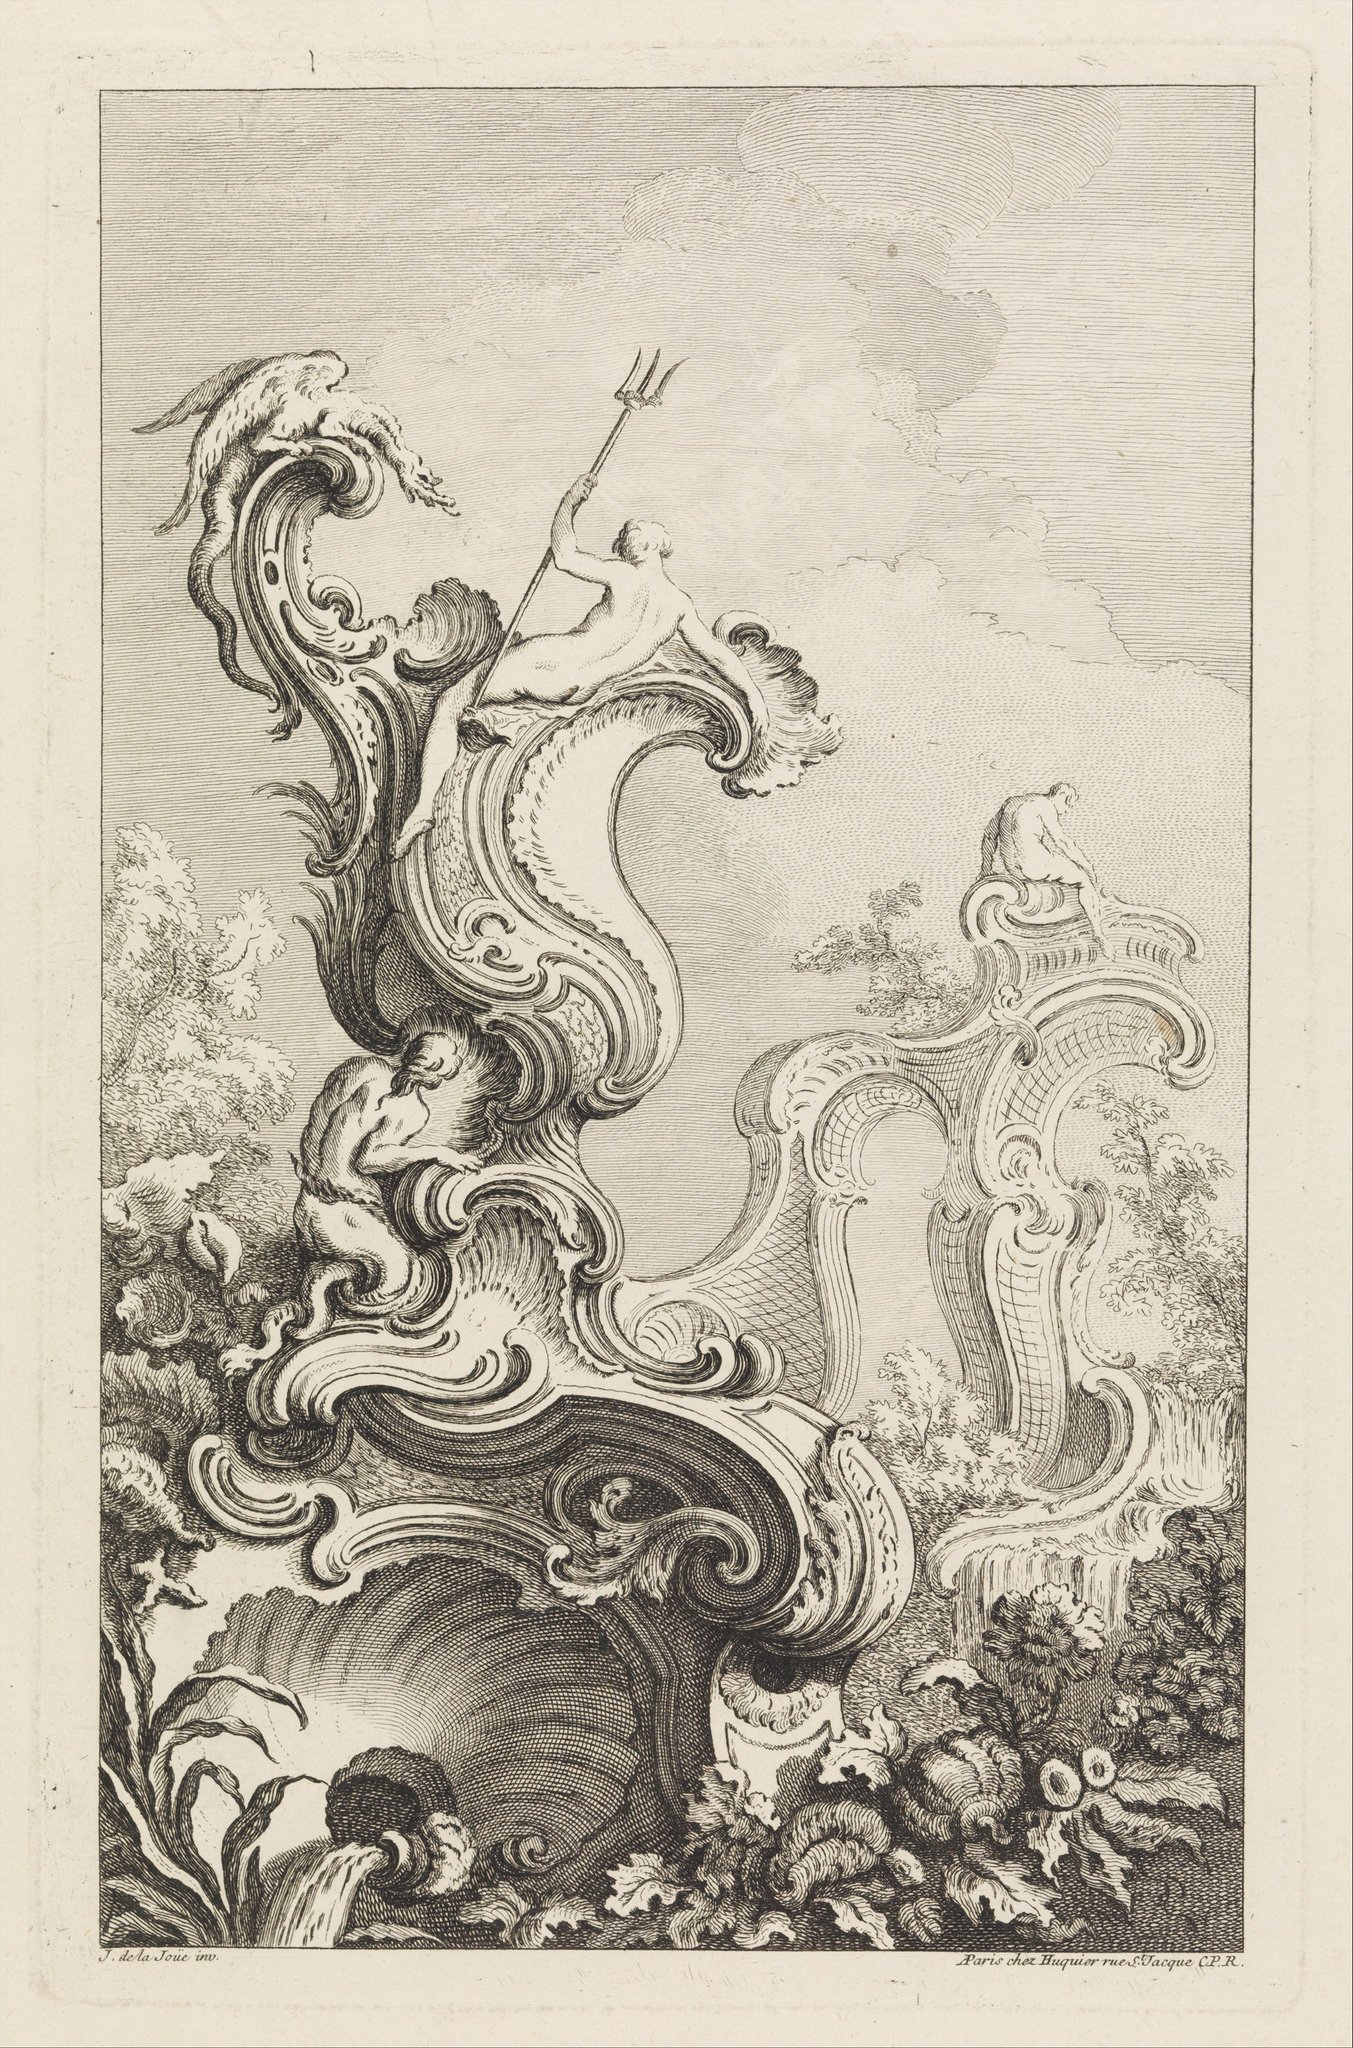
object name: book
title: Plate from Book of Vases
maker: jacques de la joue the younger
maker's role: artist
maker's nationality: french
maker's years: 1686-1761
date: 1701-1800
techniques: etching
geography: france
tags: male nudes